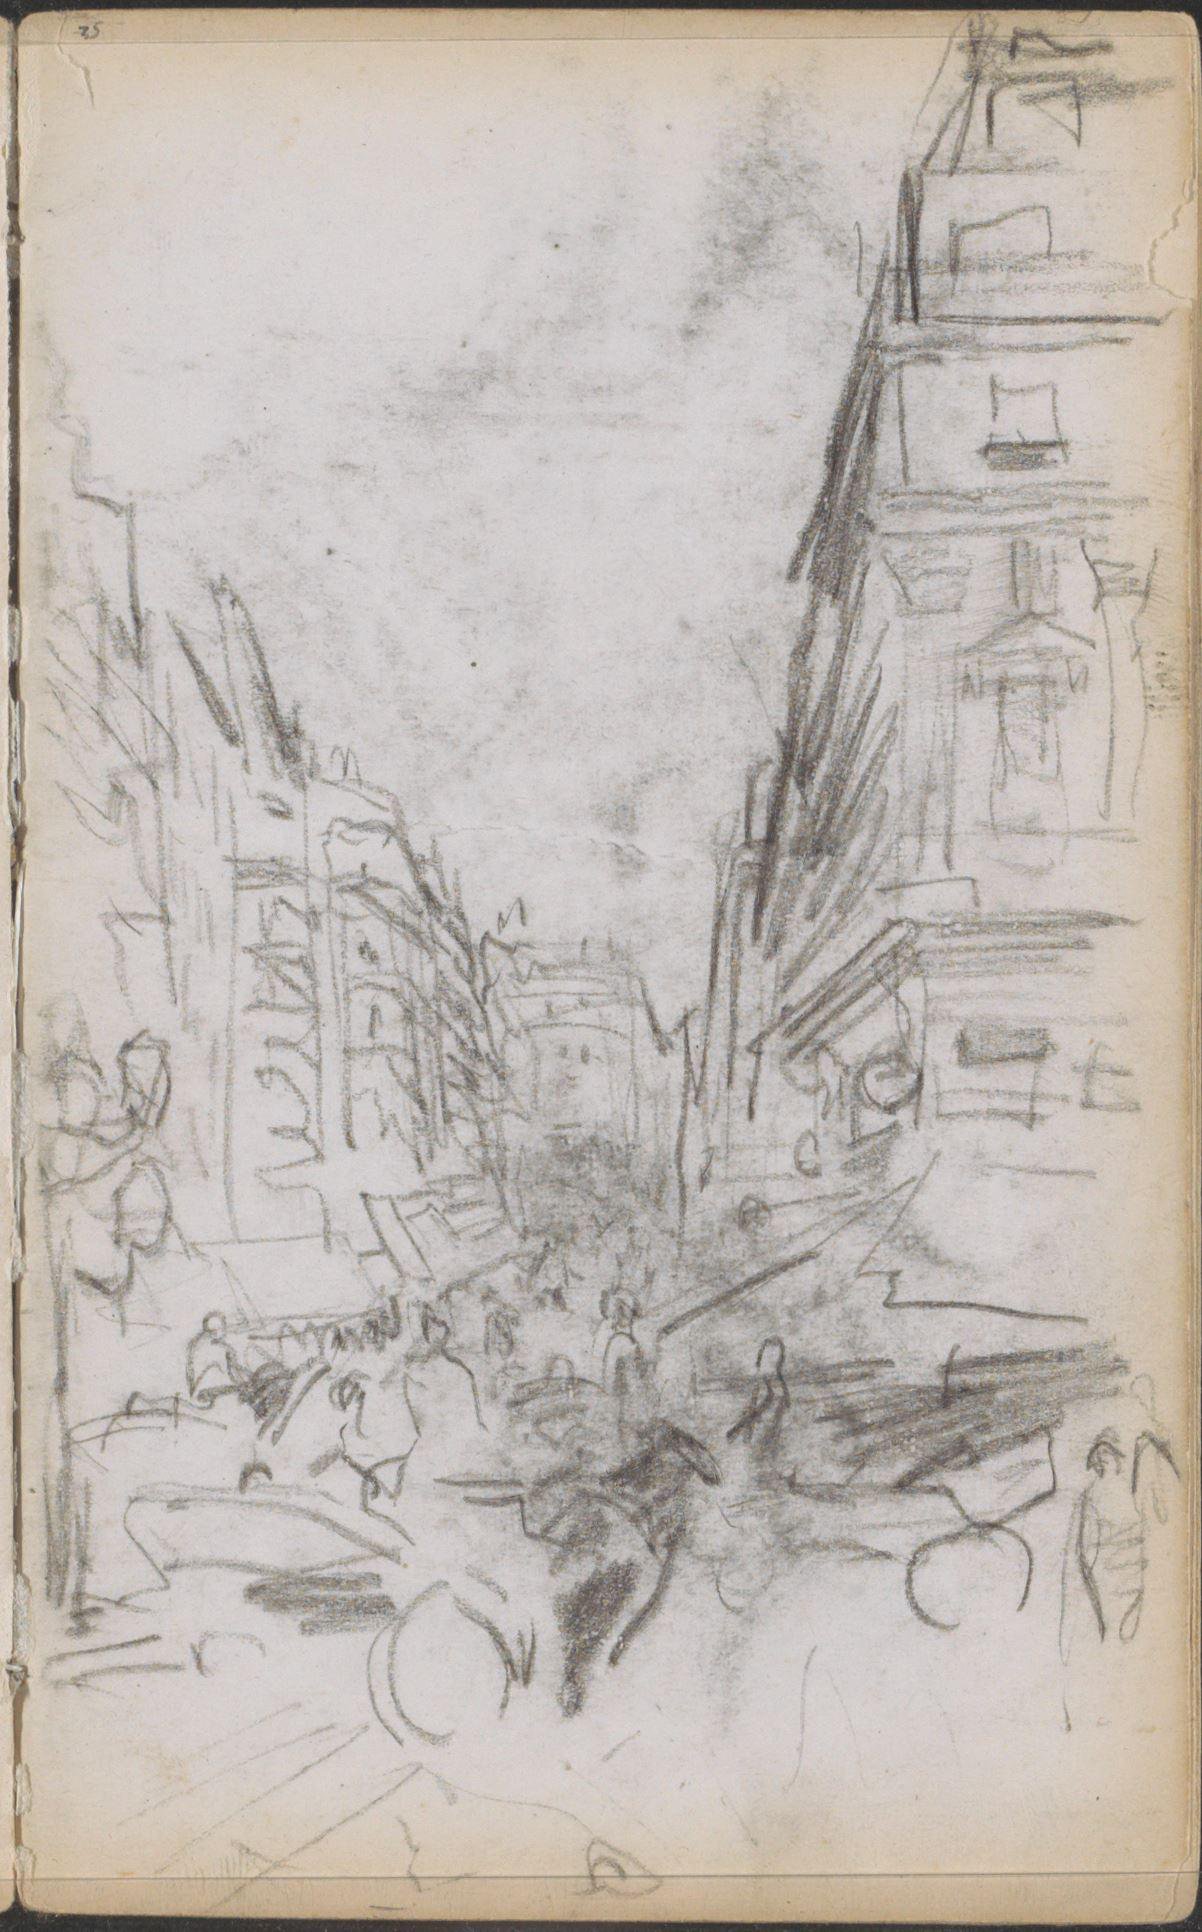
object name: sketchbook leaf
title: Kruispunt in Parijs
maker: marius bauer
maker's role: draughtsman, print maker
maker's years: 1867-1932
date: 1810-1891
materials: chalk, paper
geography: paris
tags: street lighting, street (+ city(-scape) with figures, staffage), paris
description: Gezicht op een boulevard met verkeer. Pagina 35 uit een schetsboek met 35 bladen.